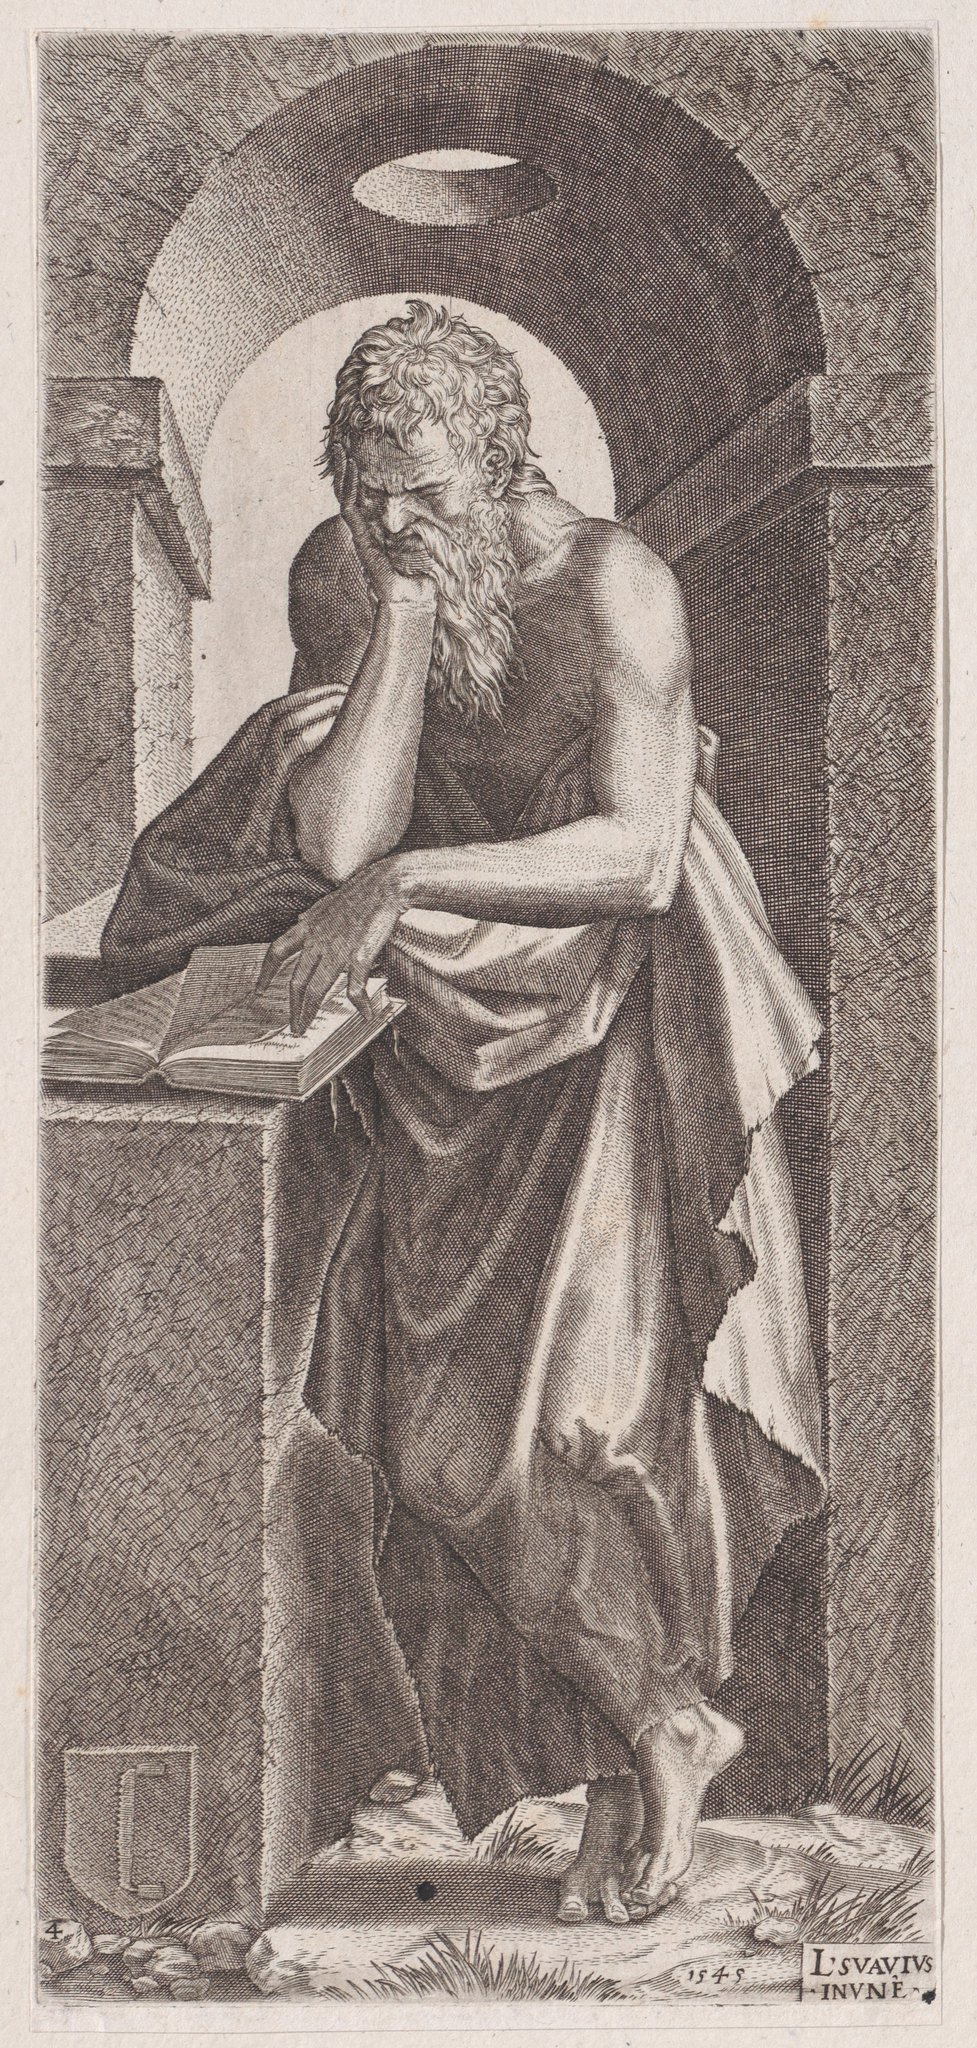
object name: print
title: St. Simon, from "Christ, the Twelve Apostles and St. Paul"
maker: lambert suavius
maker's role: artist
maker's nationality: netherlandish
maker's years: 1510-1576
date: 1525-1576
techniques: engraving